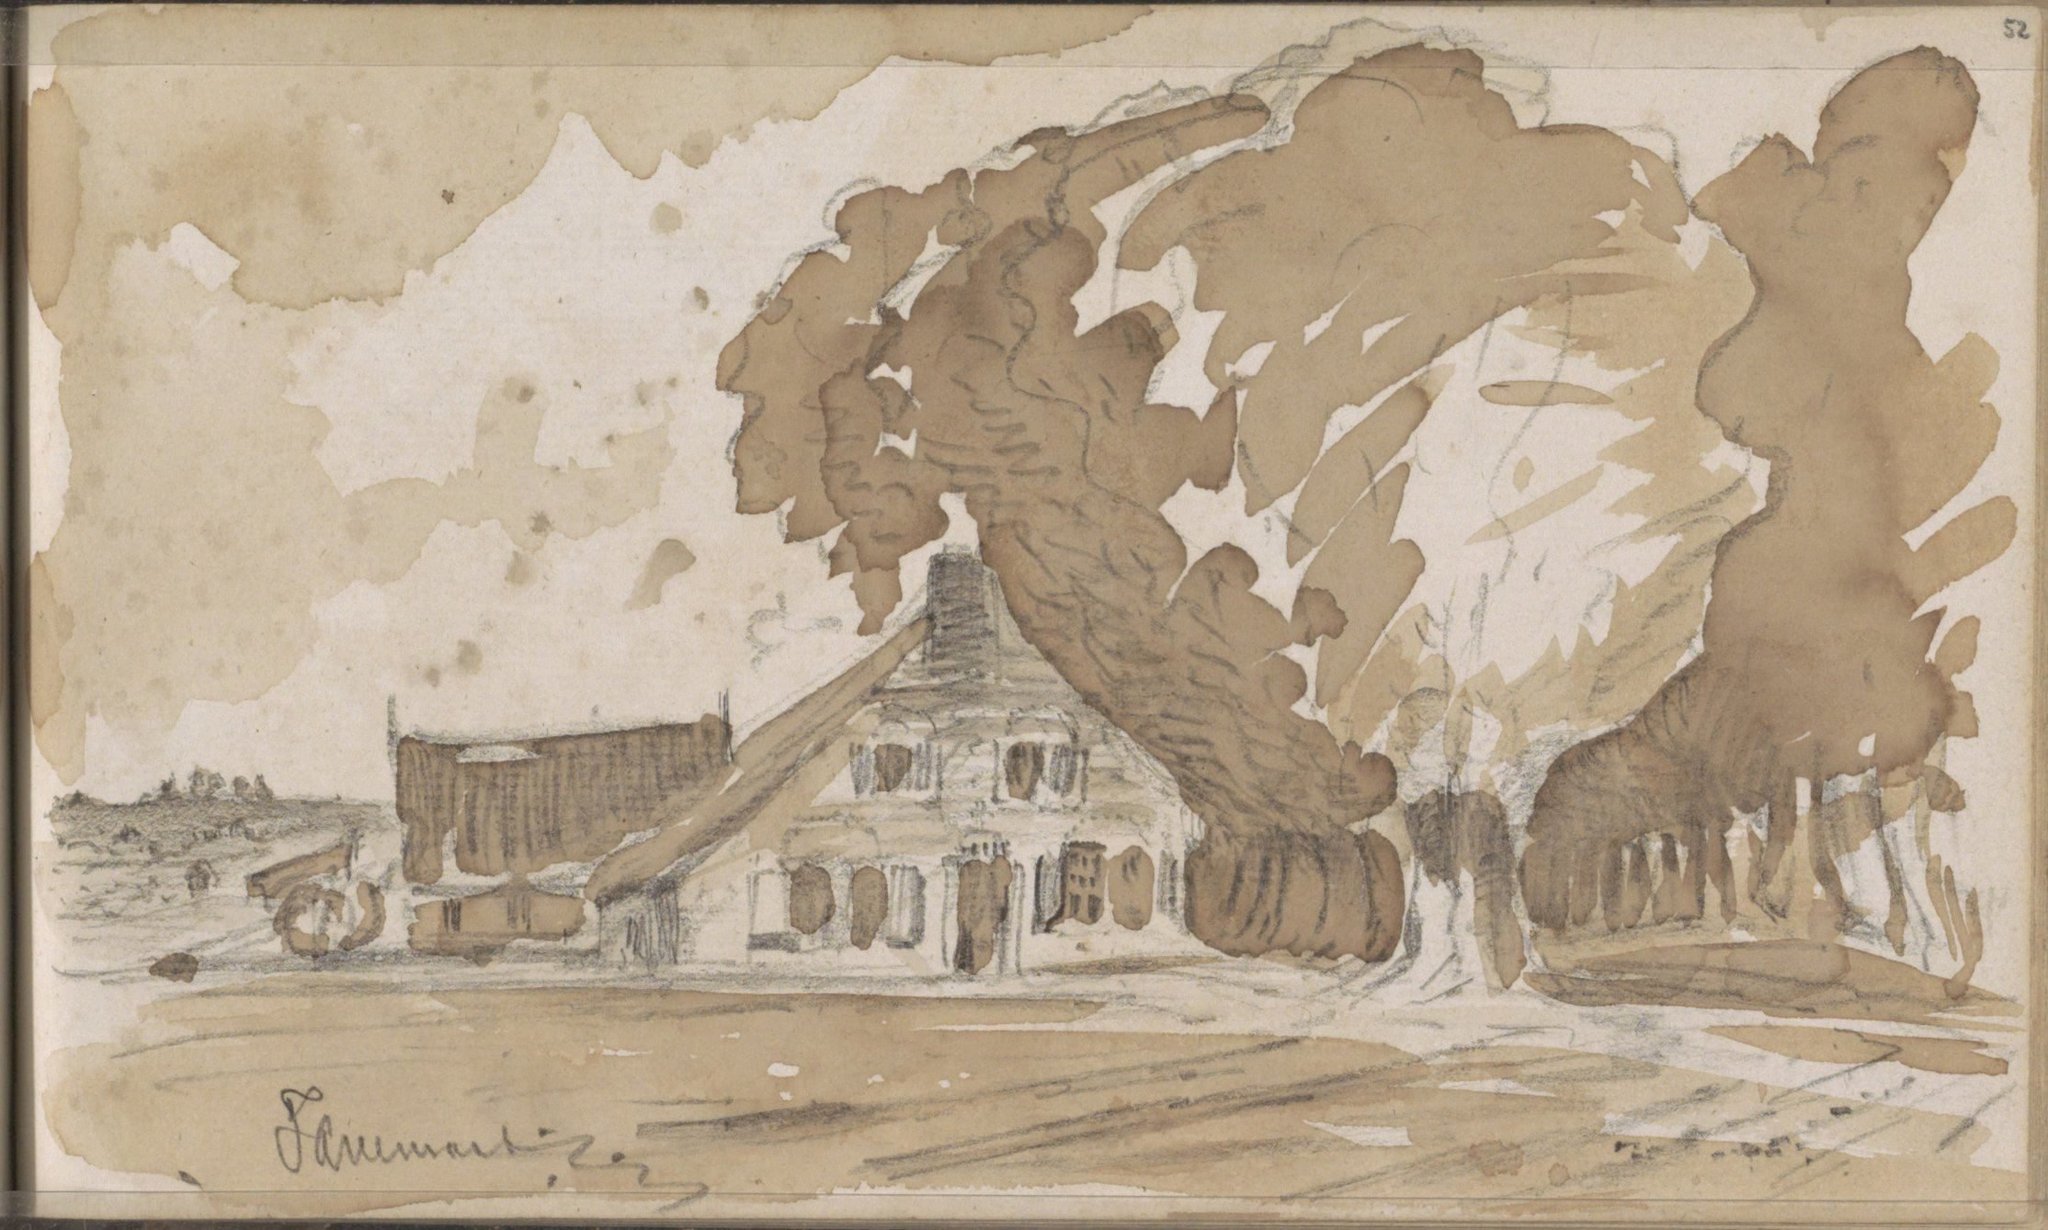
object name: sketchbook leaf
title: Huis naast een bomenpad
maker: johannes tavenraat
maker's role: draughtsman, painter, print maker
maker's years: 1809-1881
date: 1864-1880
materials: ink, paper, pencil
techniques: brush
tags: trees, rural housing, e.g. country-house, villa, cottage, road, path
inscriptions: signature: ‘Tavenraat’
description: Blad 52 recto uit een schetsboek met 98 bladen.